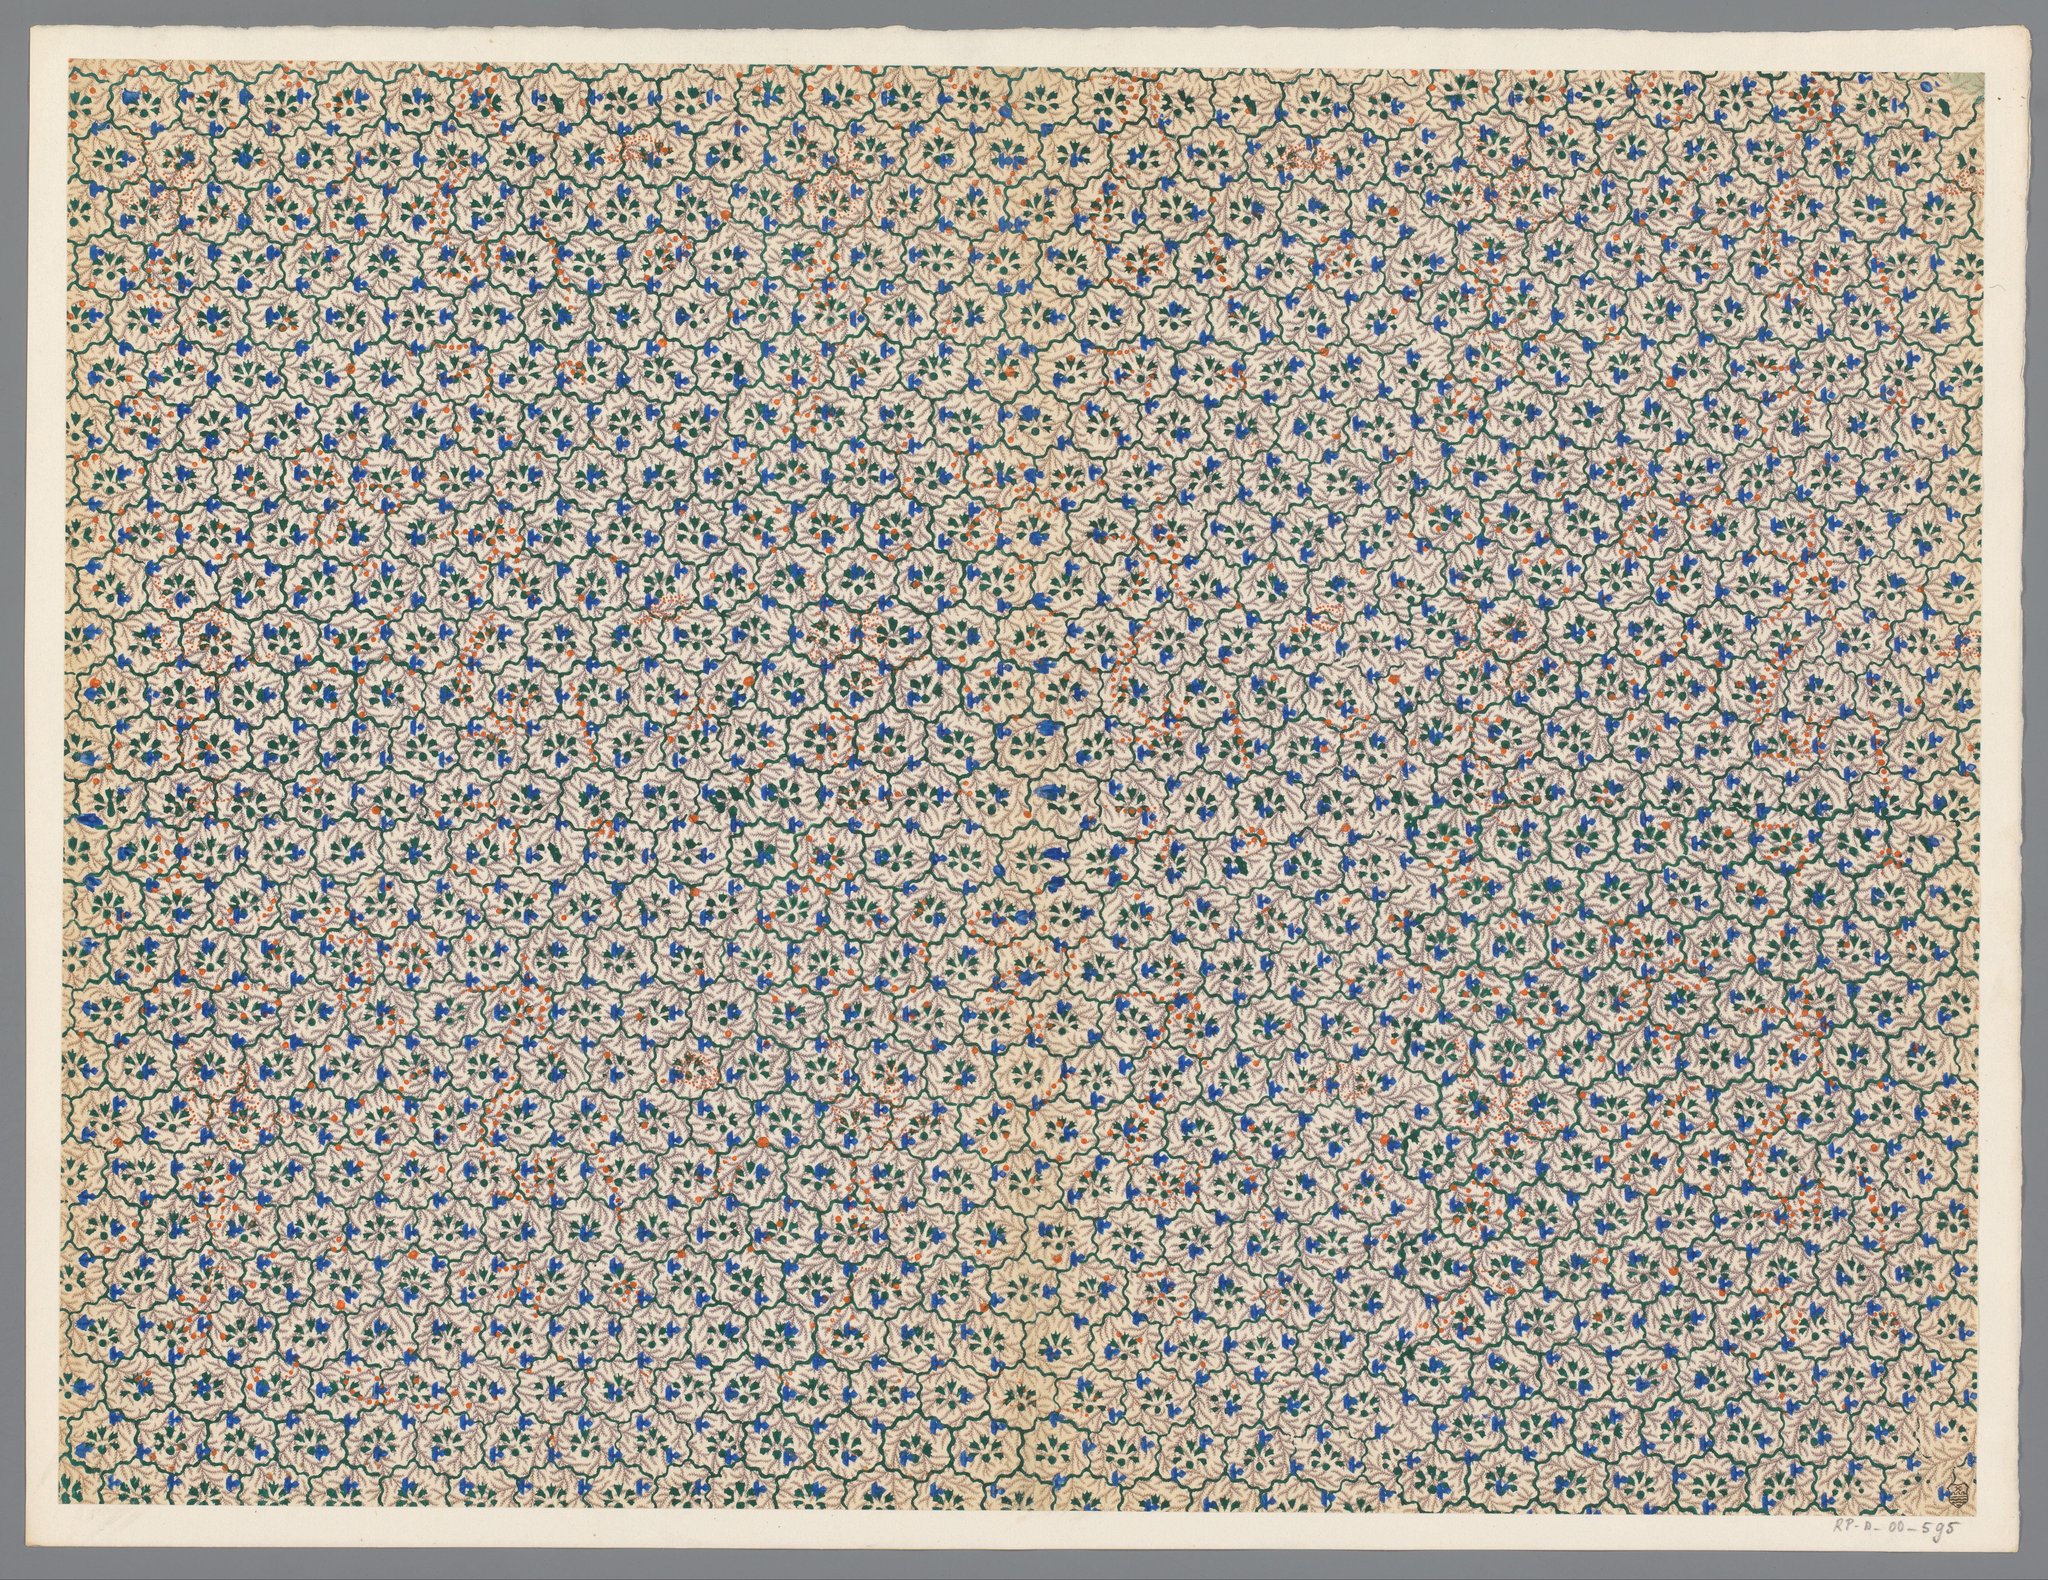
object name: printed paper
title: Blad met banenpatroon van zeshoekig vorm met bloemmotief over een fond van fijnvertakte ranken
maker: Anonymous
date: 1800-1900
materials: paper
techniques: printing block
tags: ornament derived from plant forms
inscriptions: collector's mark: Lugt 2760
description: Blad met horizontaal banenpatroon van zeshoekachtig vorm met bloemmotief over een fond van fijnvertakte ranken.